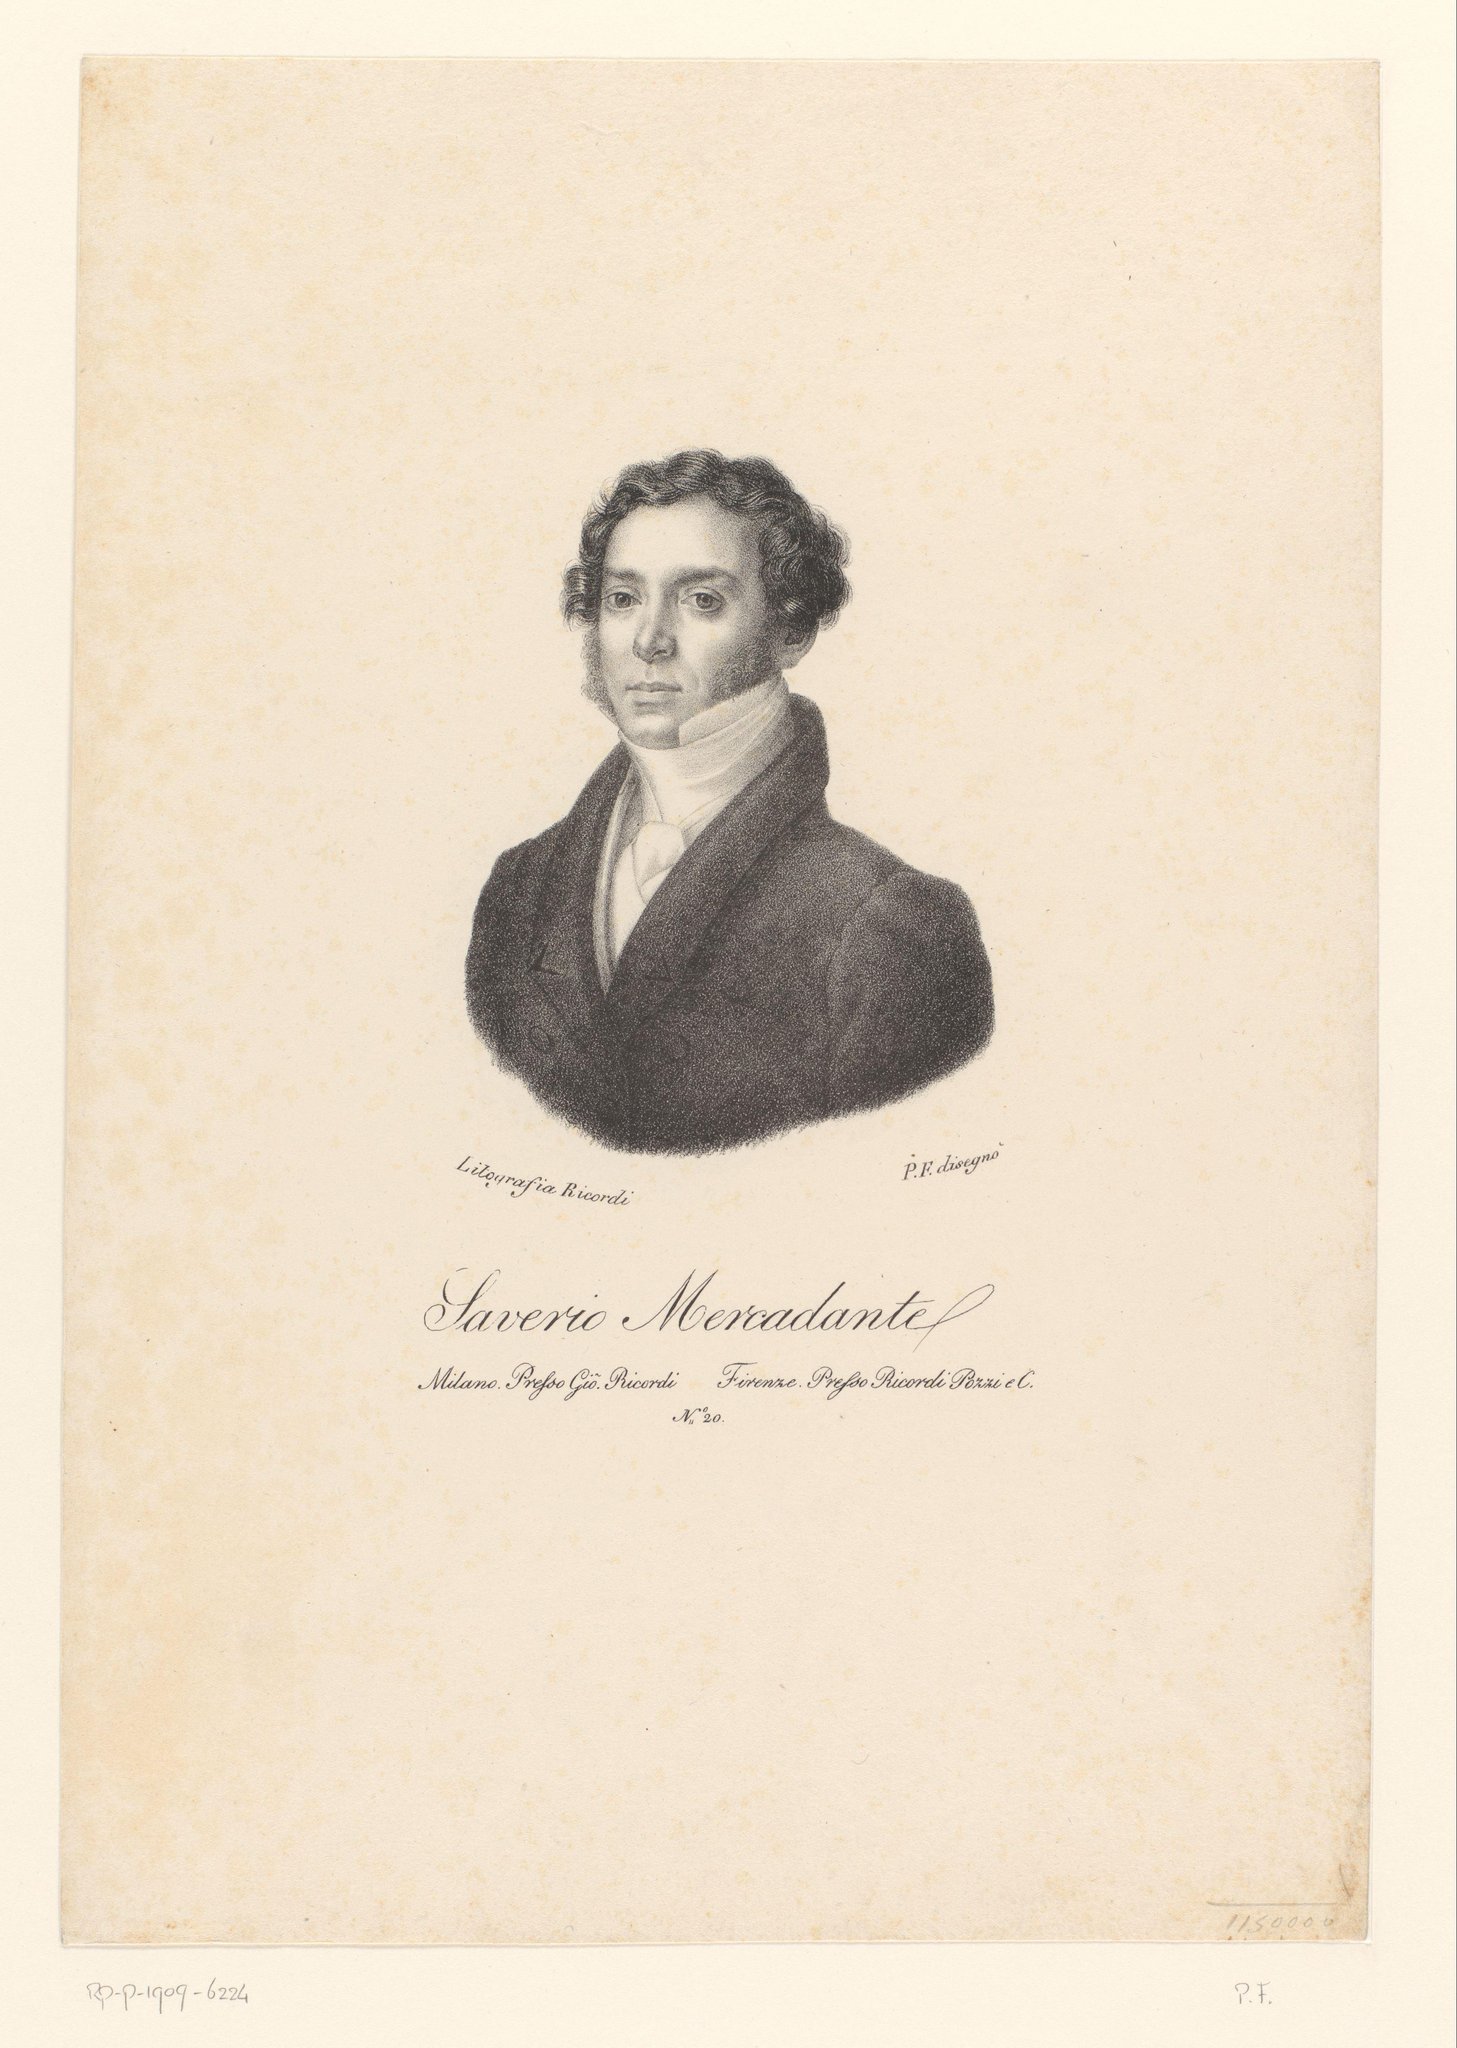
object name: print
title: Portret van componist en muziekpedagoog Saverio Mercadante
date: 1800-1899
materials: paper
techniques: lithograph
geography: italy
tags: historical persons, portrait of composer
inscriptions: collector's mark: Lugt 2228